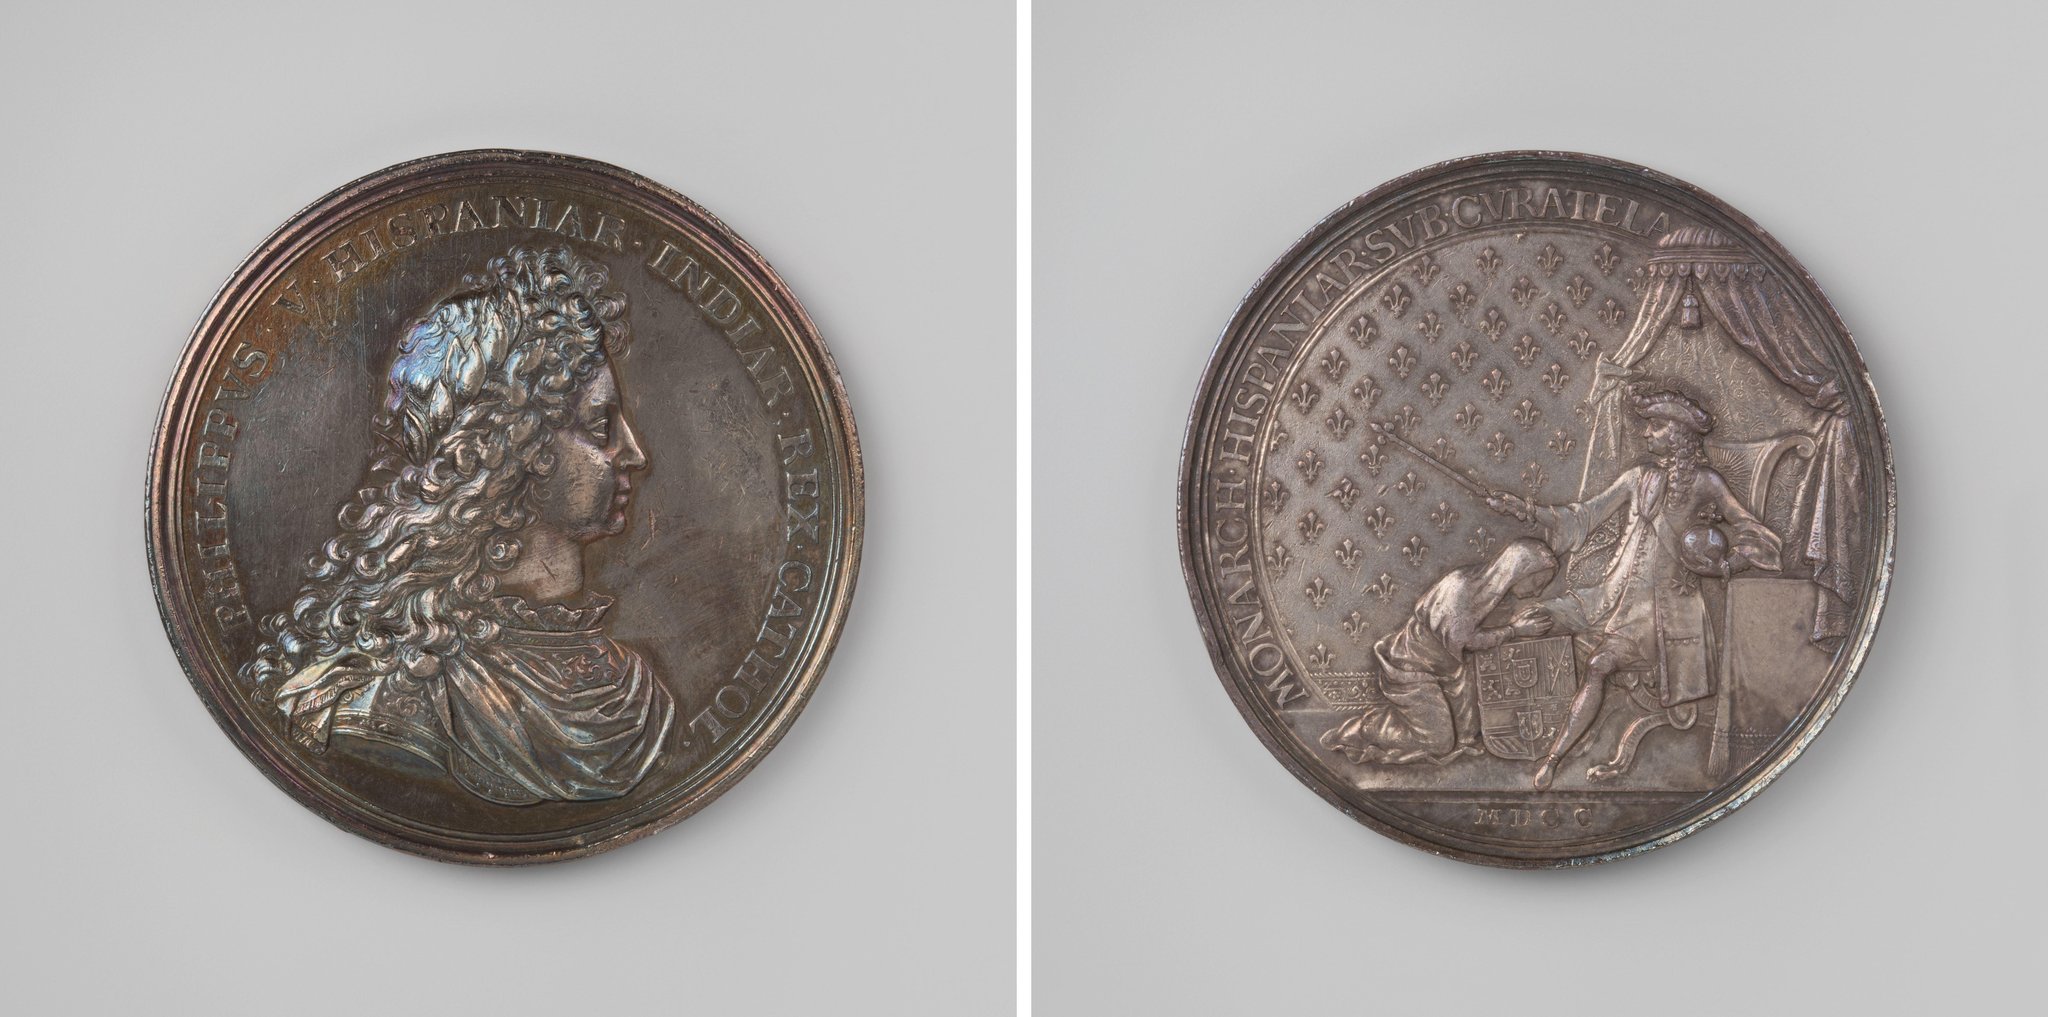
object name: satirical medal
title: Aanvaarding van de Spaanse troon door Filips van Anjou onder Franse voogdij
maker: Anonymous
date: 1700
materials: silver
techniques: striking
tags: lodewijk xiv (koning van frankrijk), filips v (koning van spanje), spain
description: Zilveren penning. Voorzijde: borststuk man met lauwerkrans binnen omschrift. Keerzijde: Spanje, in de gedaante van een knielende vrouw met wapenschild kust been van Franse koning die zittend op troon rijksappel en scepter met lelie in handen houdt binnen omschrift, boven opschrift